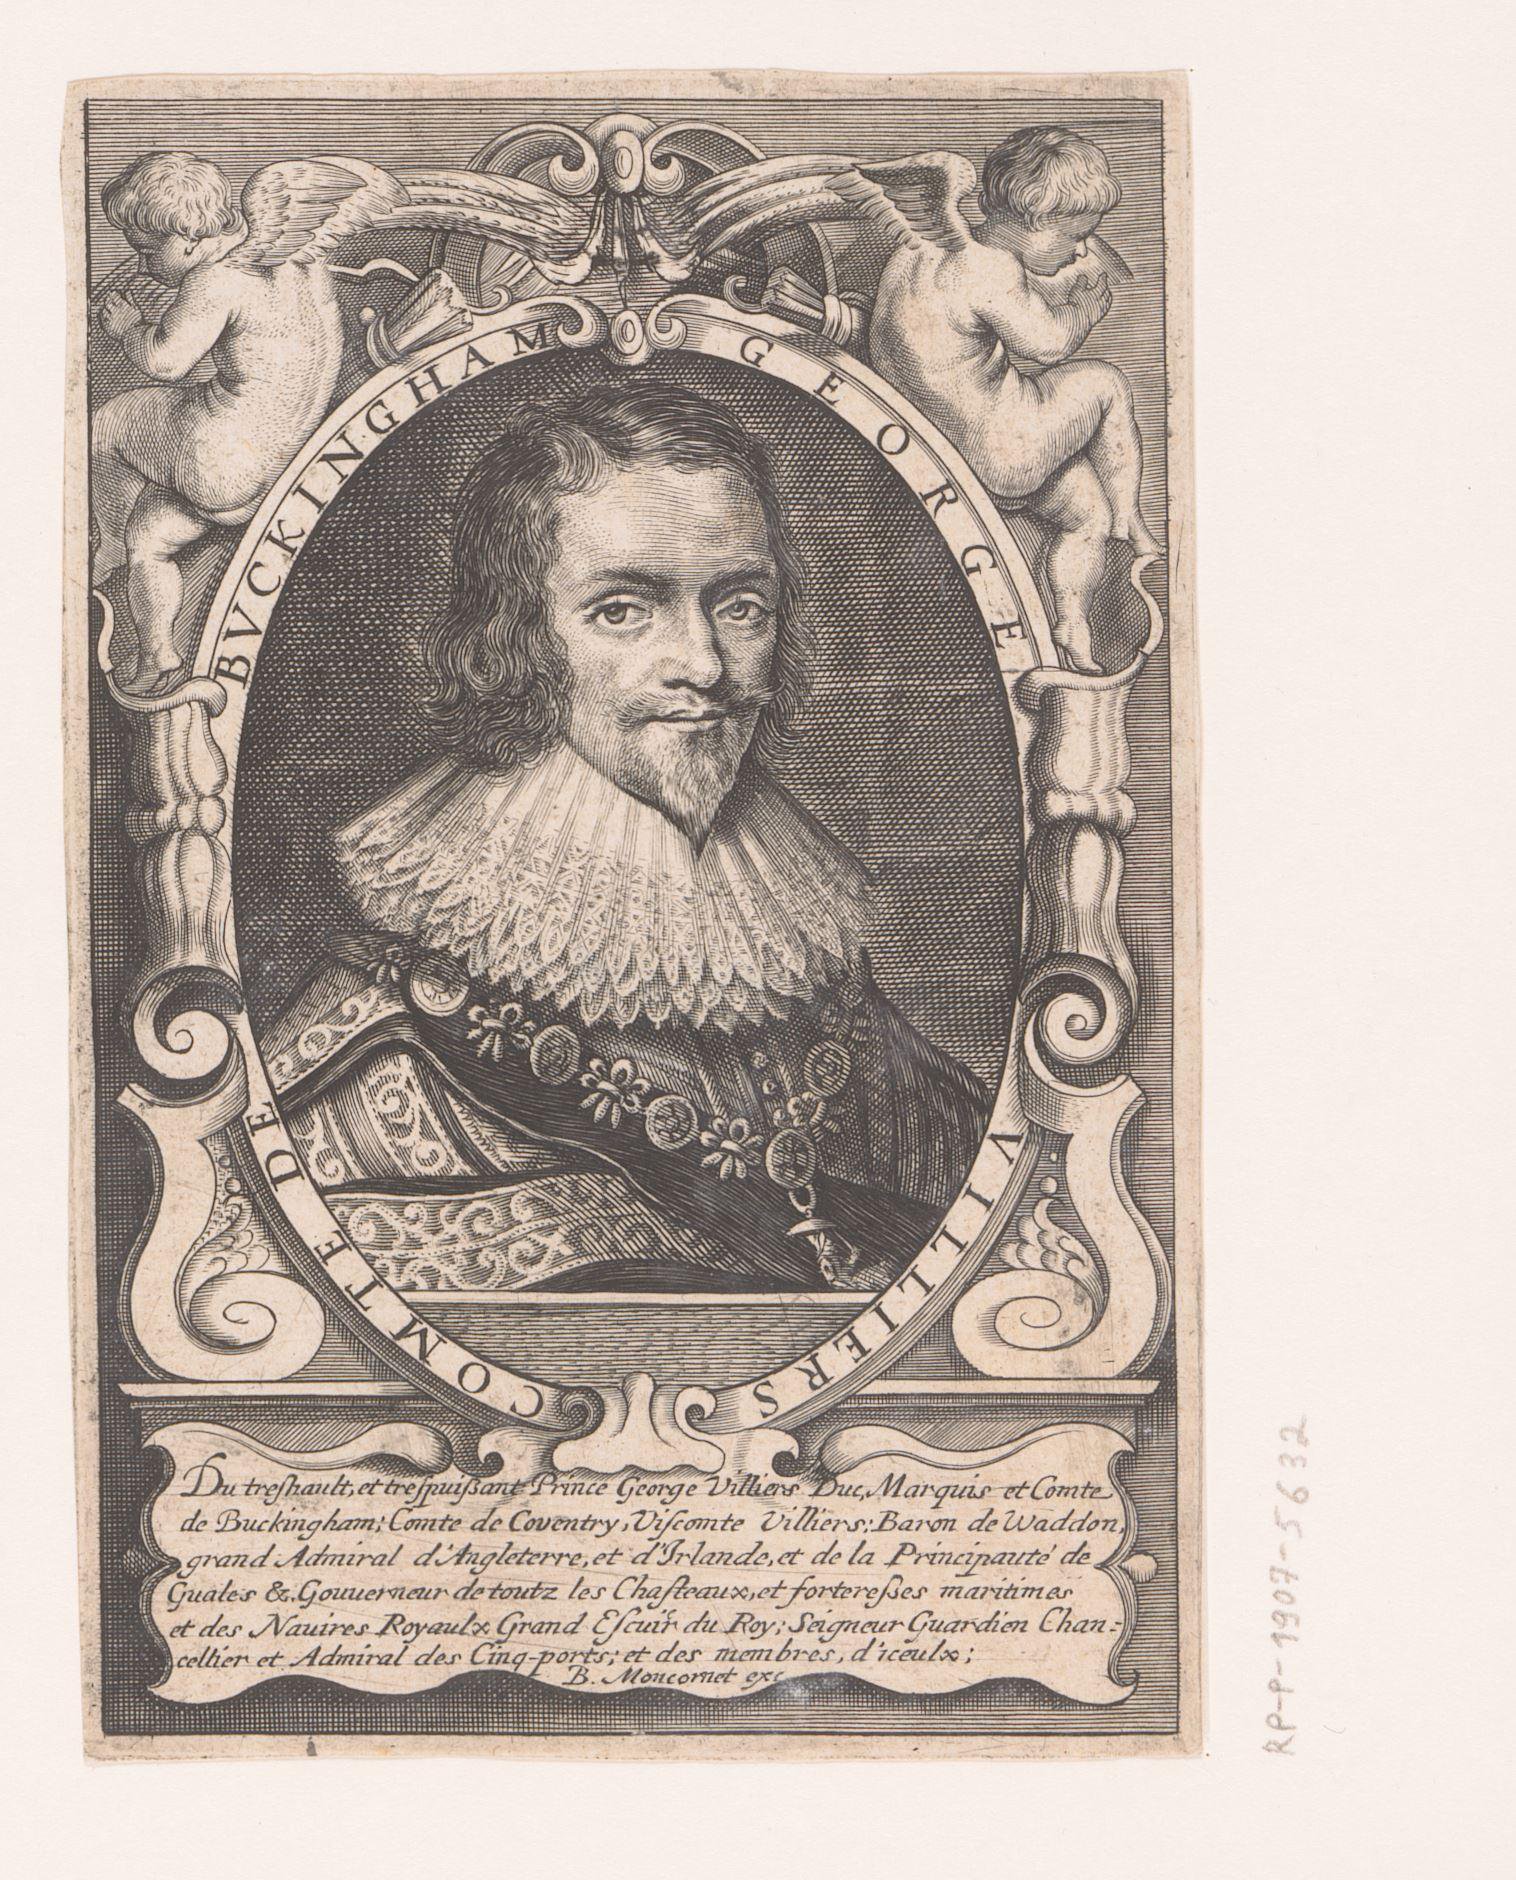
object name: print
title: Portret van George Villiers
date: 1622-1668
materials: paper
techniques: engraving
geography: paris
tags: george villiers (1st duke of buckingham), historical persons, nobility and patriciate; chivalry, knighthood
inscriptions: collector's mark: Lugt 2228